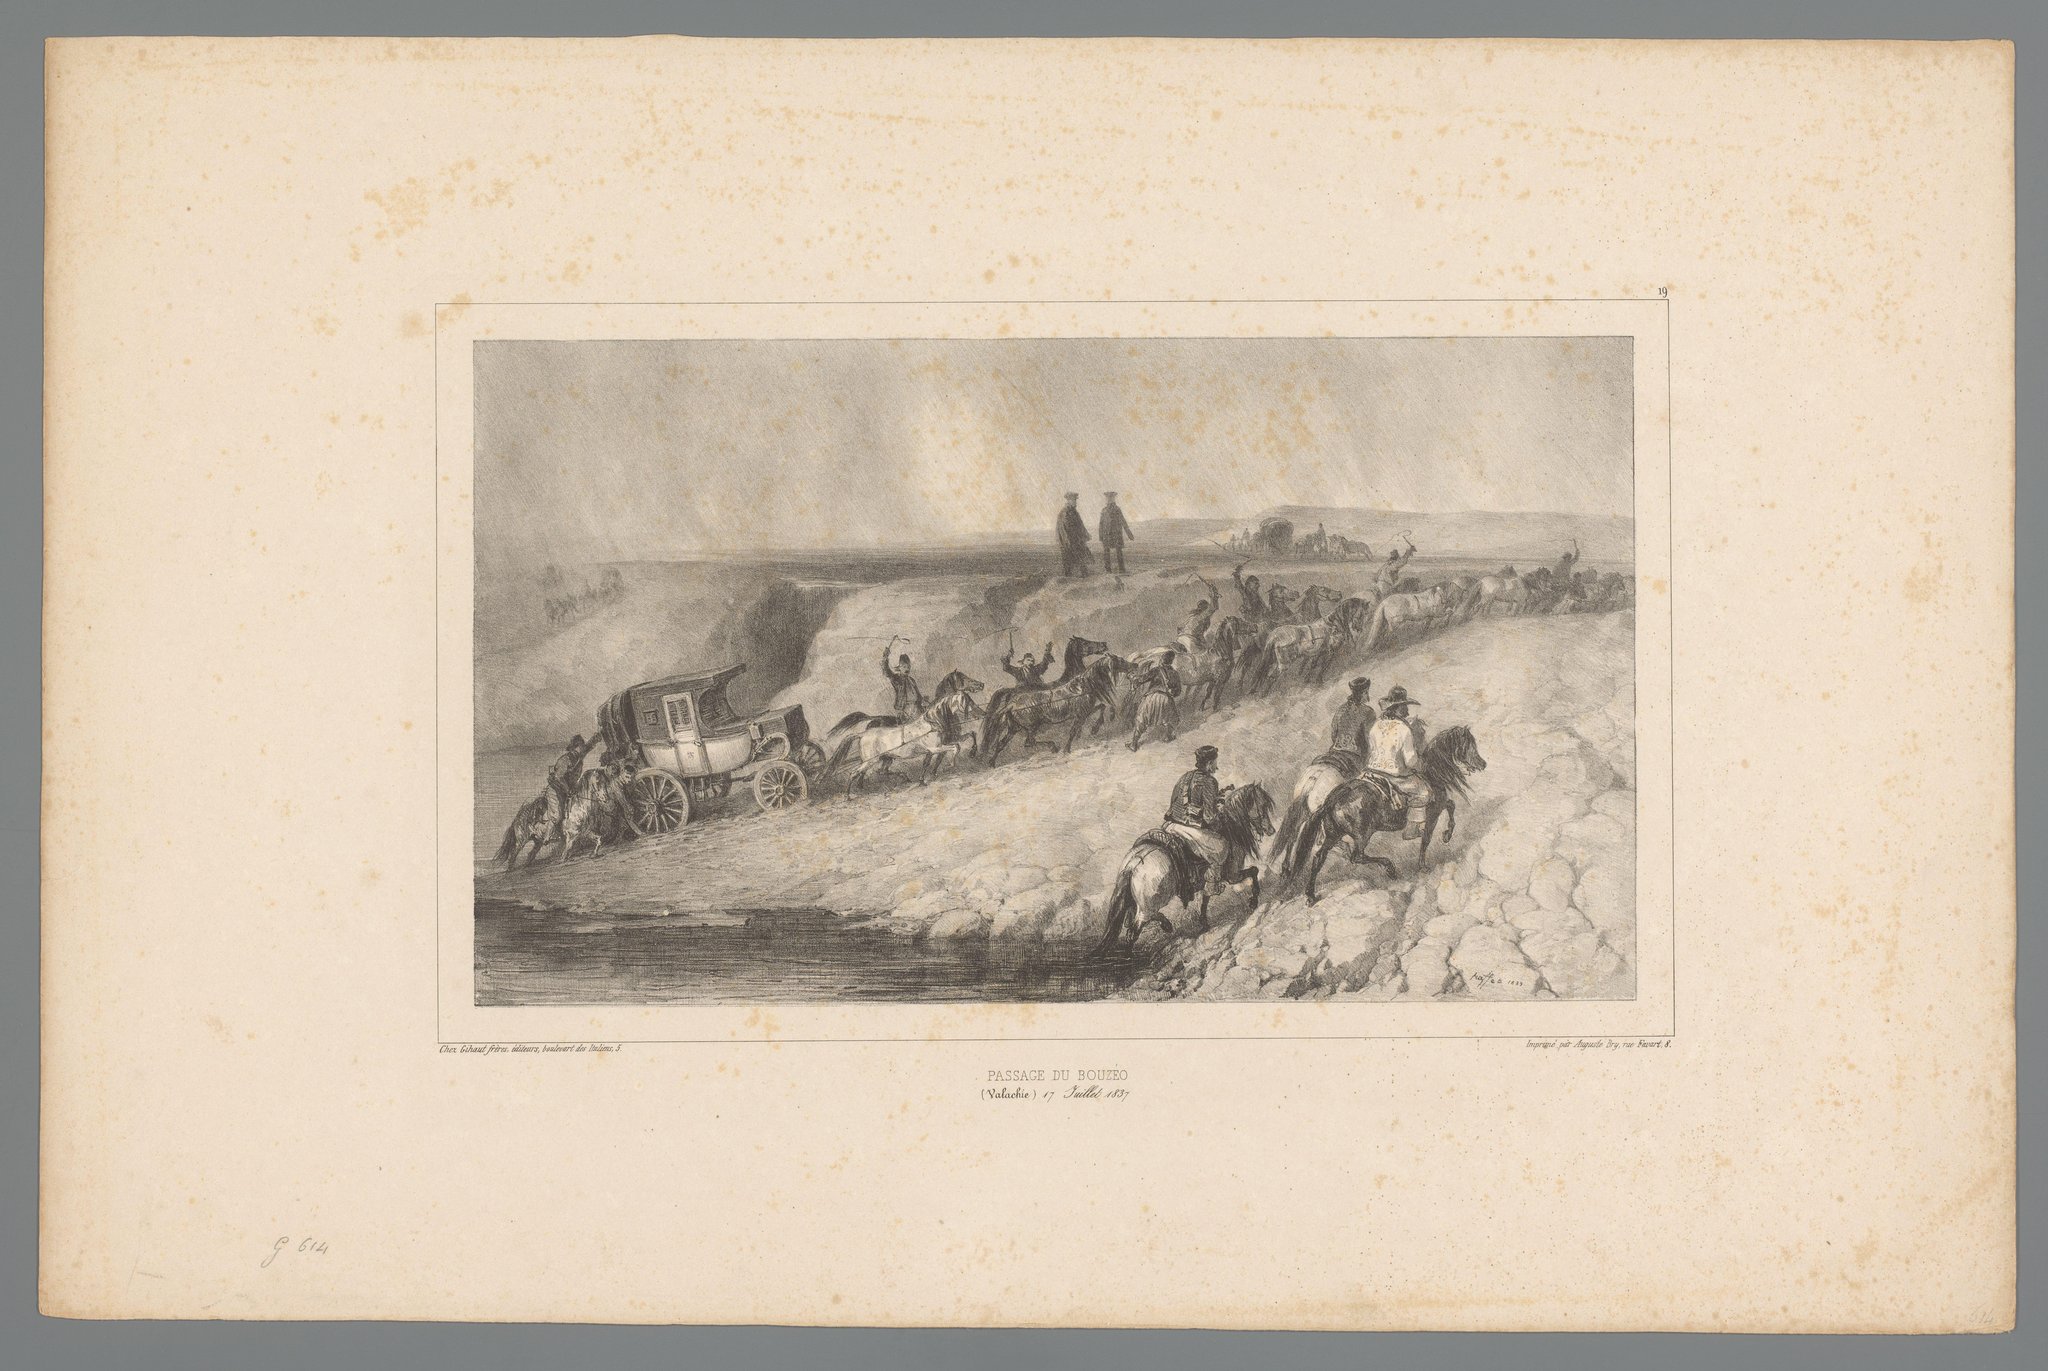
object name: print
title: Reis door Zuid-Rusland en de Krim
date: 1839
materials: paper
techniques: lithograph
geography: paris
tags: riding a horse, ass, or mule; rider, horseman, horse, passenger carriage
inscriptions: collector's mark: Lugt 964